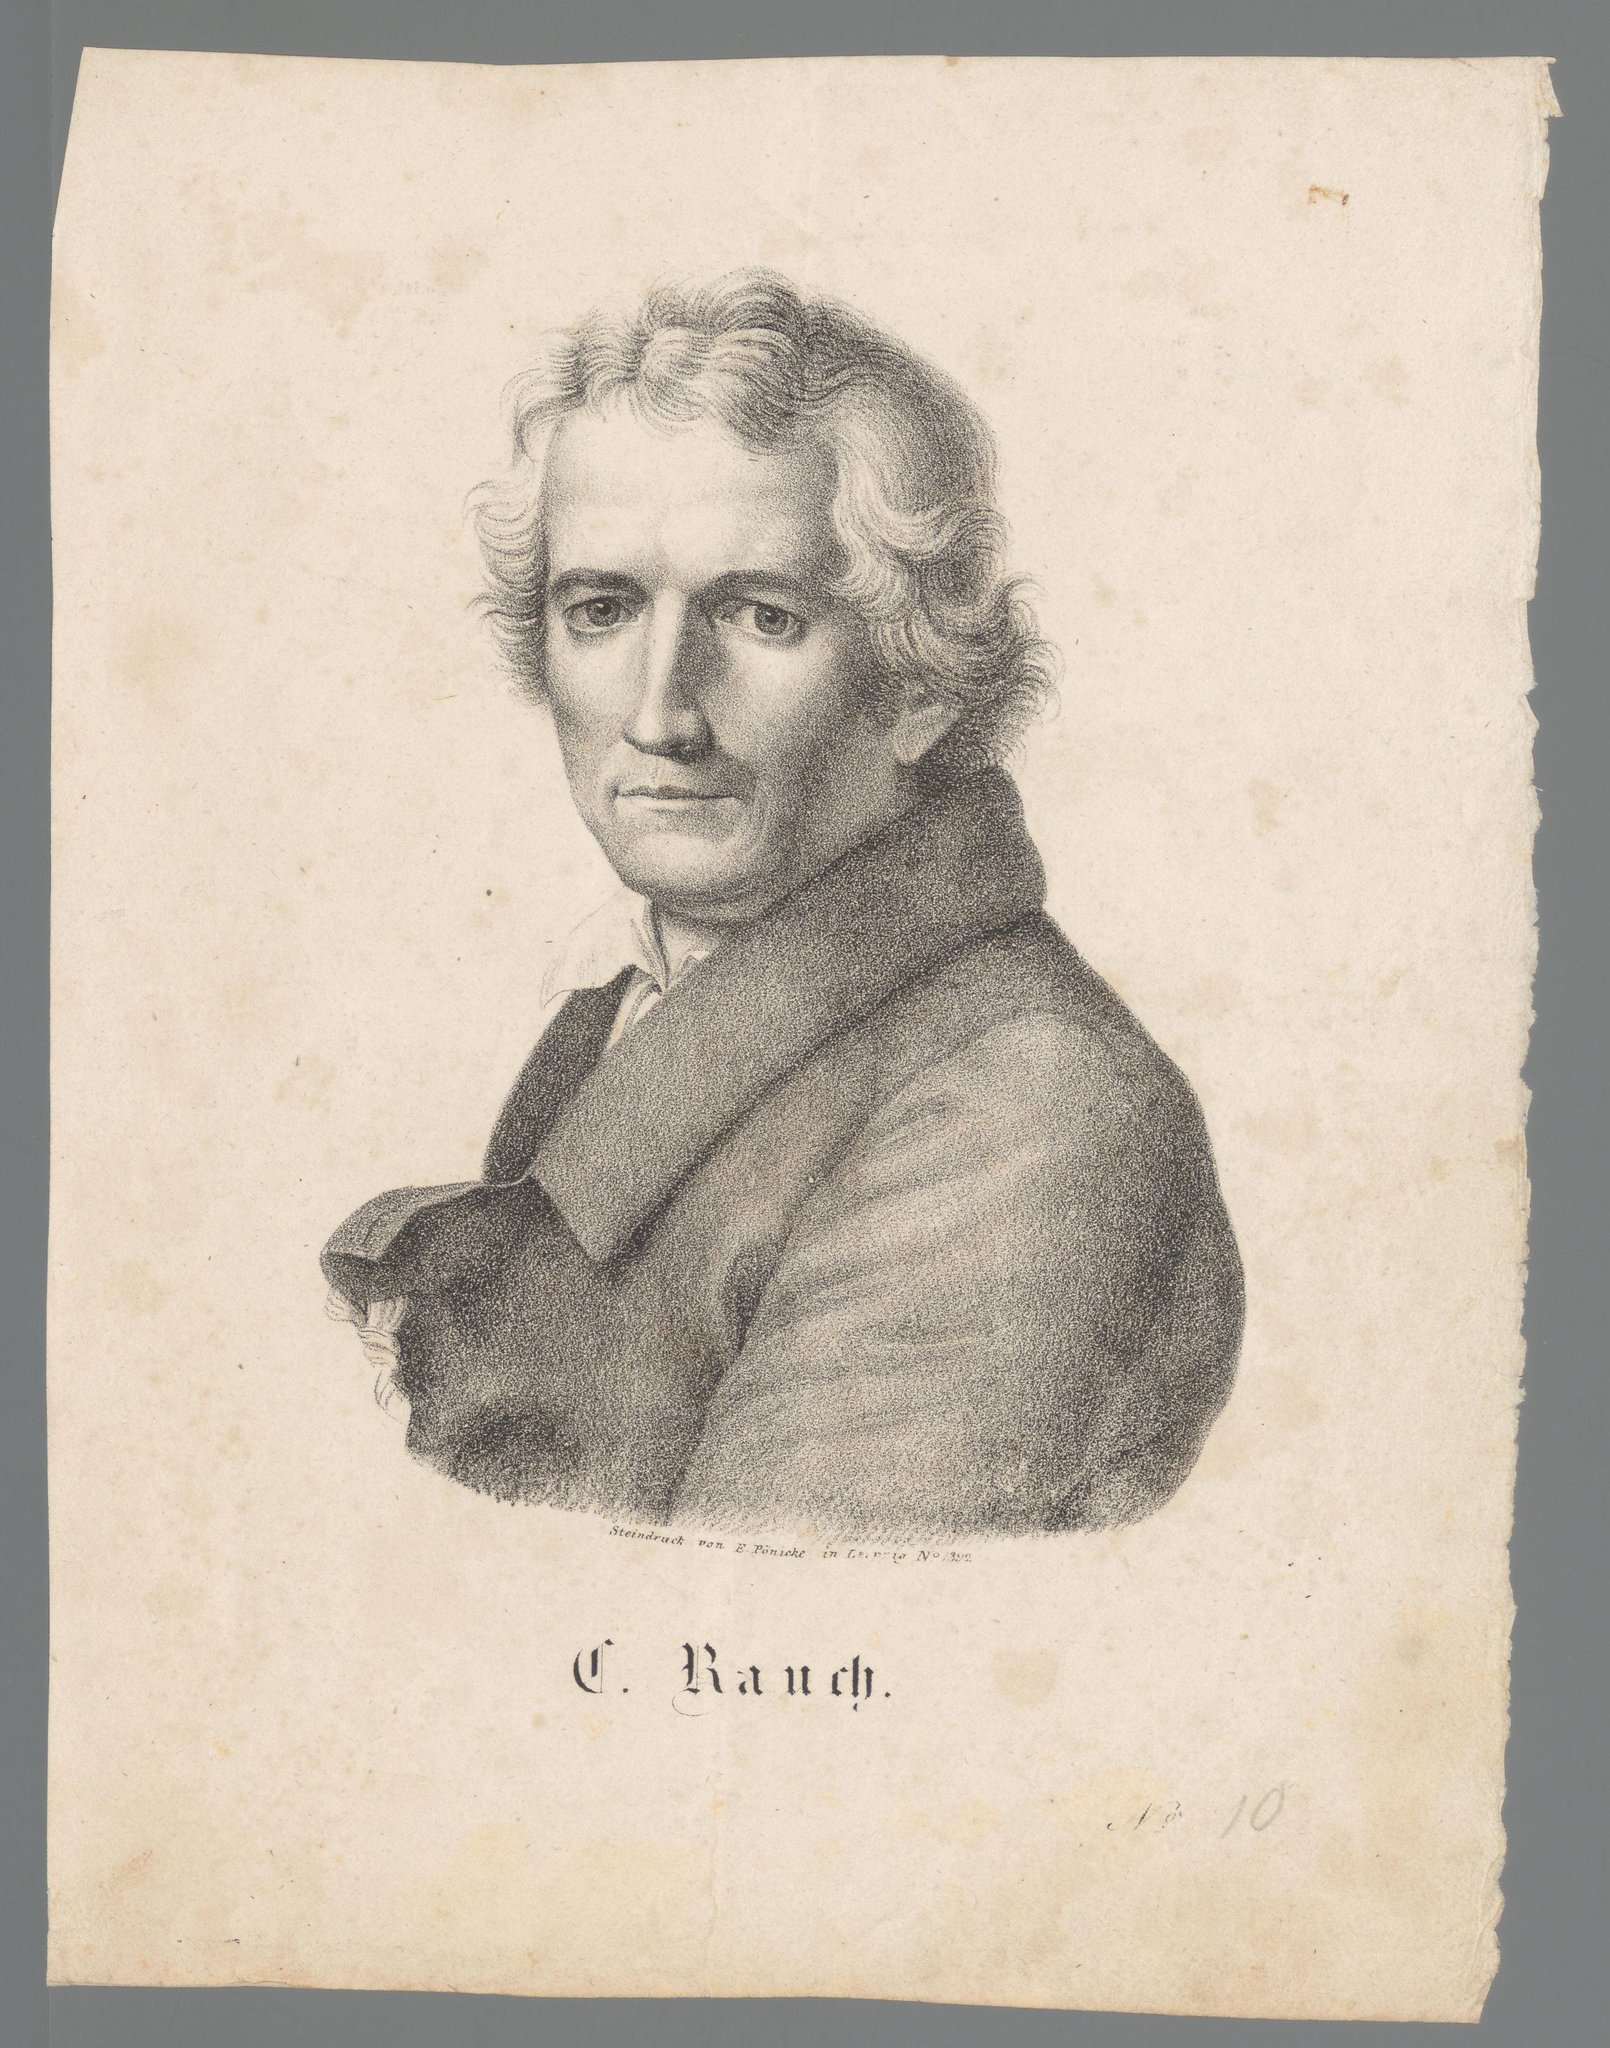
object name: print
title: Portret van Christian Daniel Rauch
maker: Anonymous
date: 1820-1875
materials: paper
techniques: lithograph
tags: sculptor, christian daniel rauch, adult man, historical persons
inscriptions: collector's mark: Lugt 2228